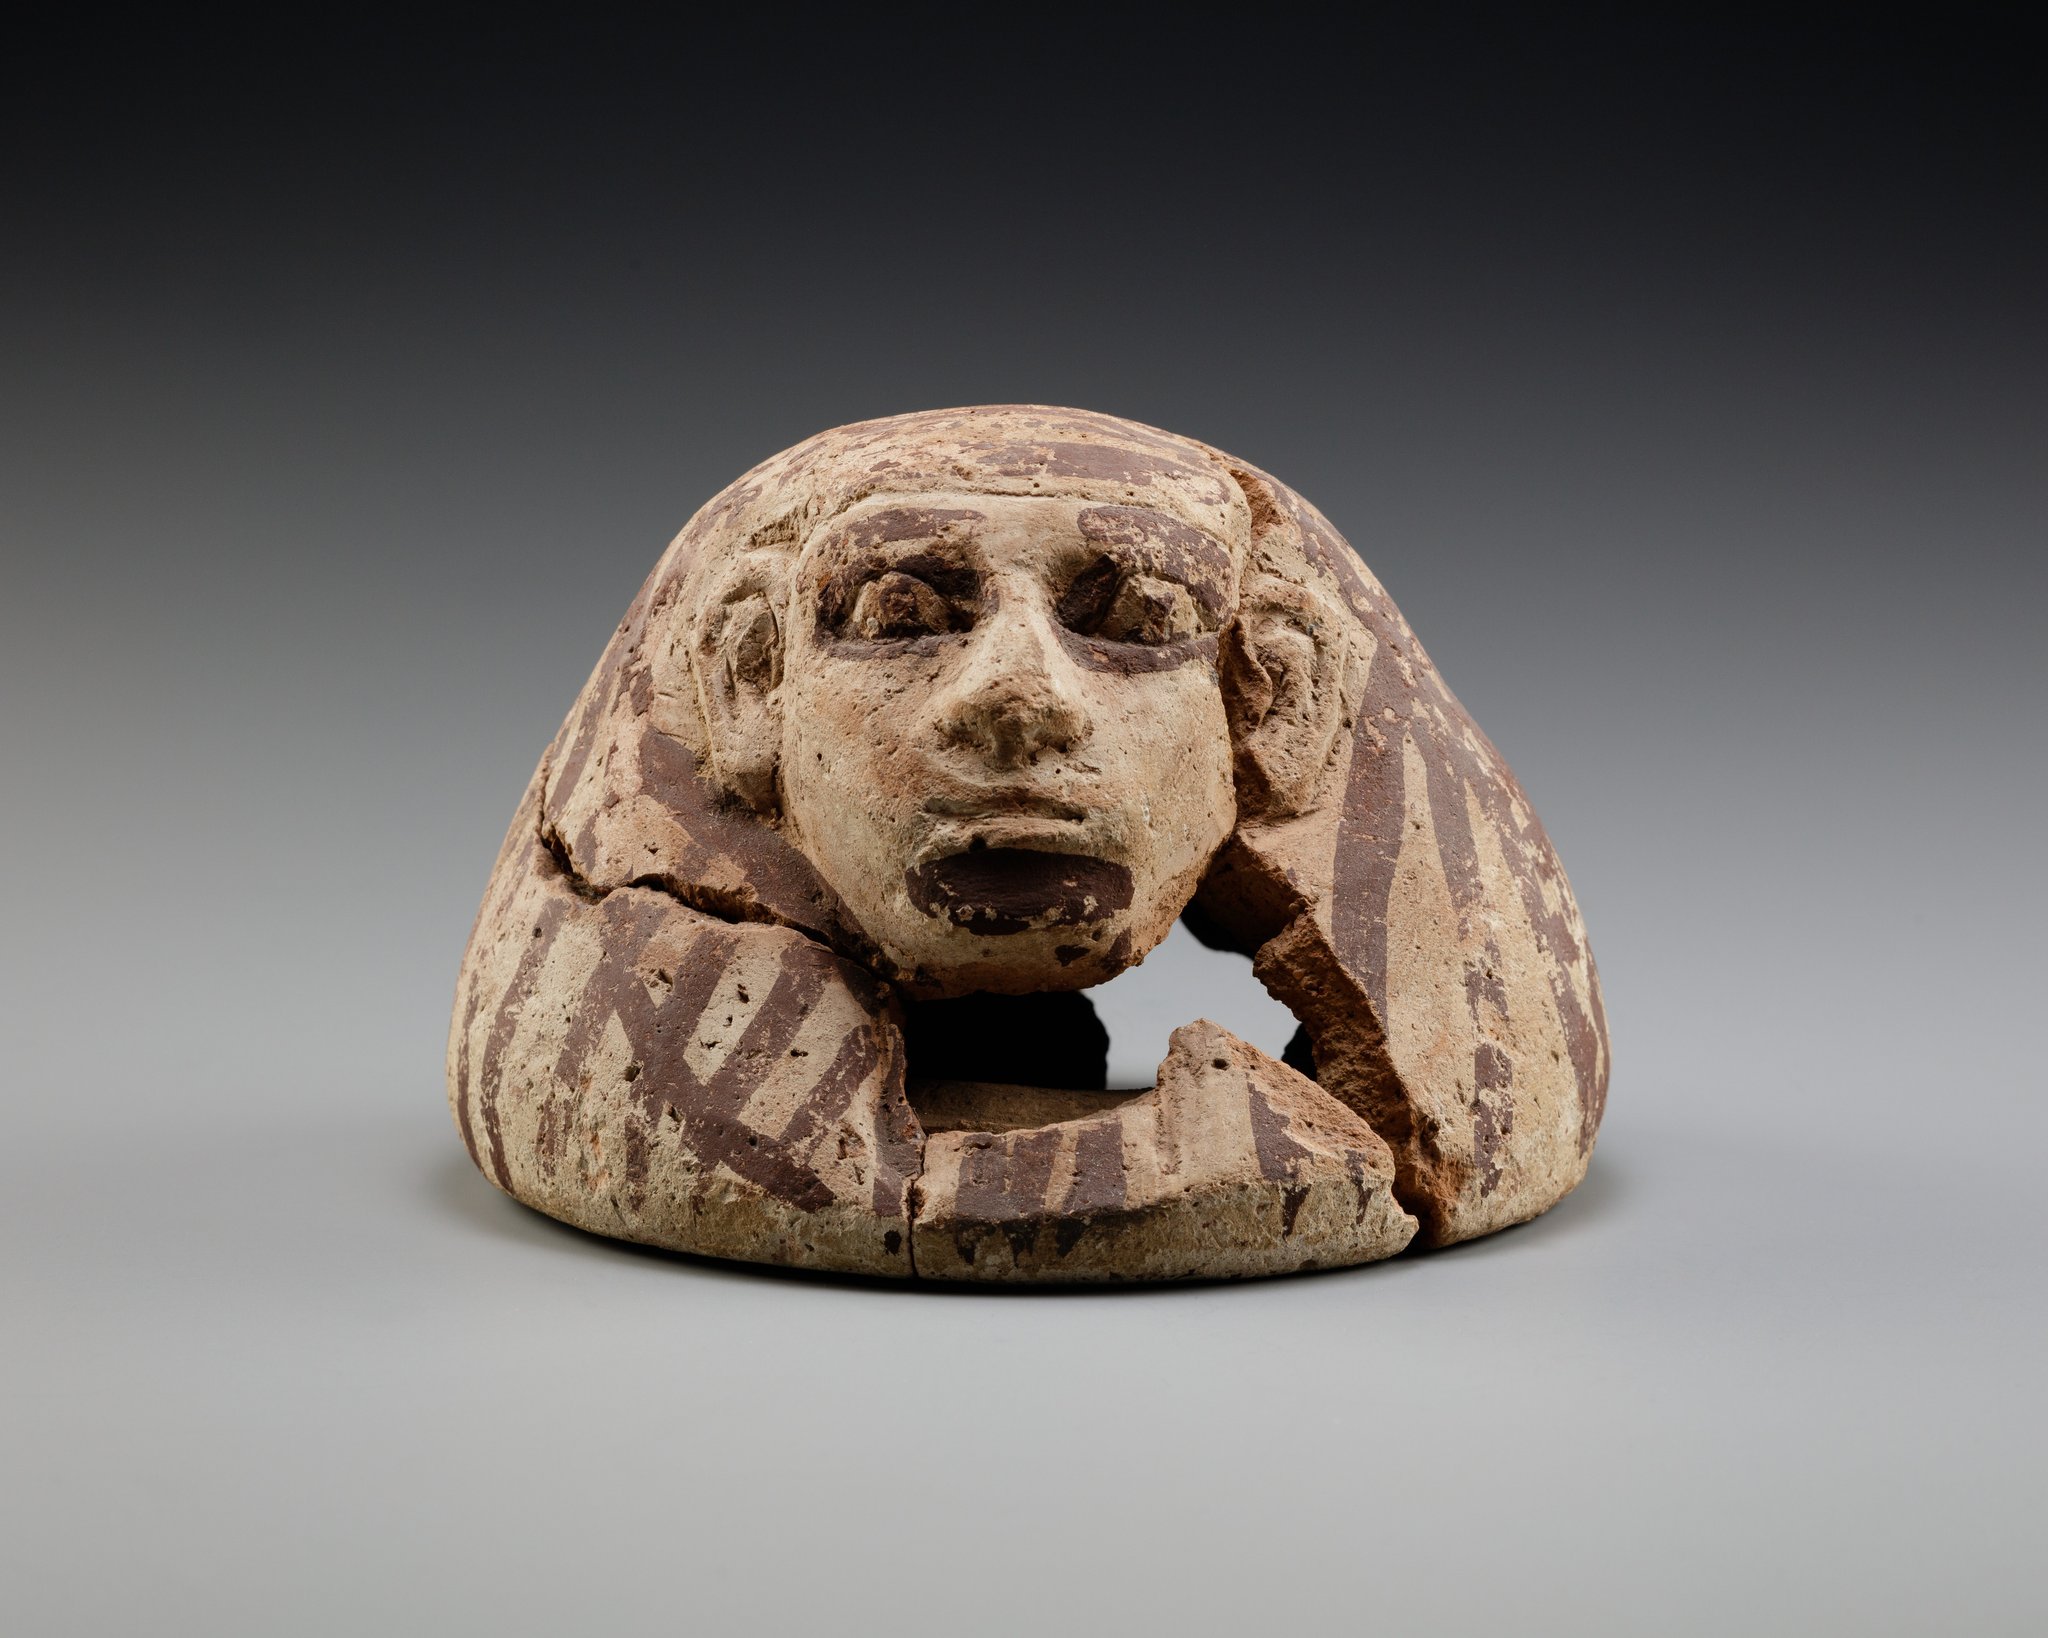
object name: canopic jar lid, senimen, human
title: Canopic Jar Lid Belonging to Senimen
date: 1479-1458 BCE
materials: paint, pottery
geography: egypt